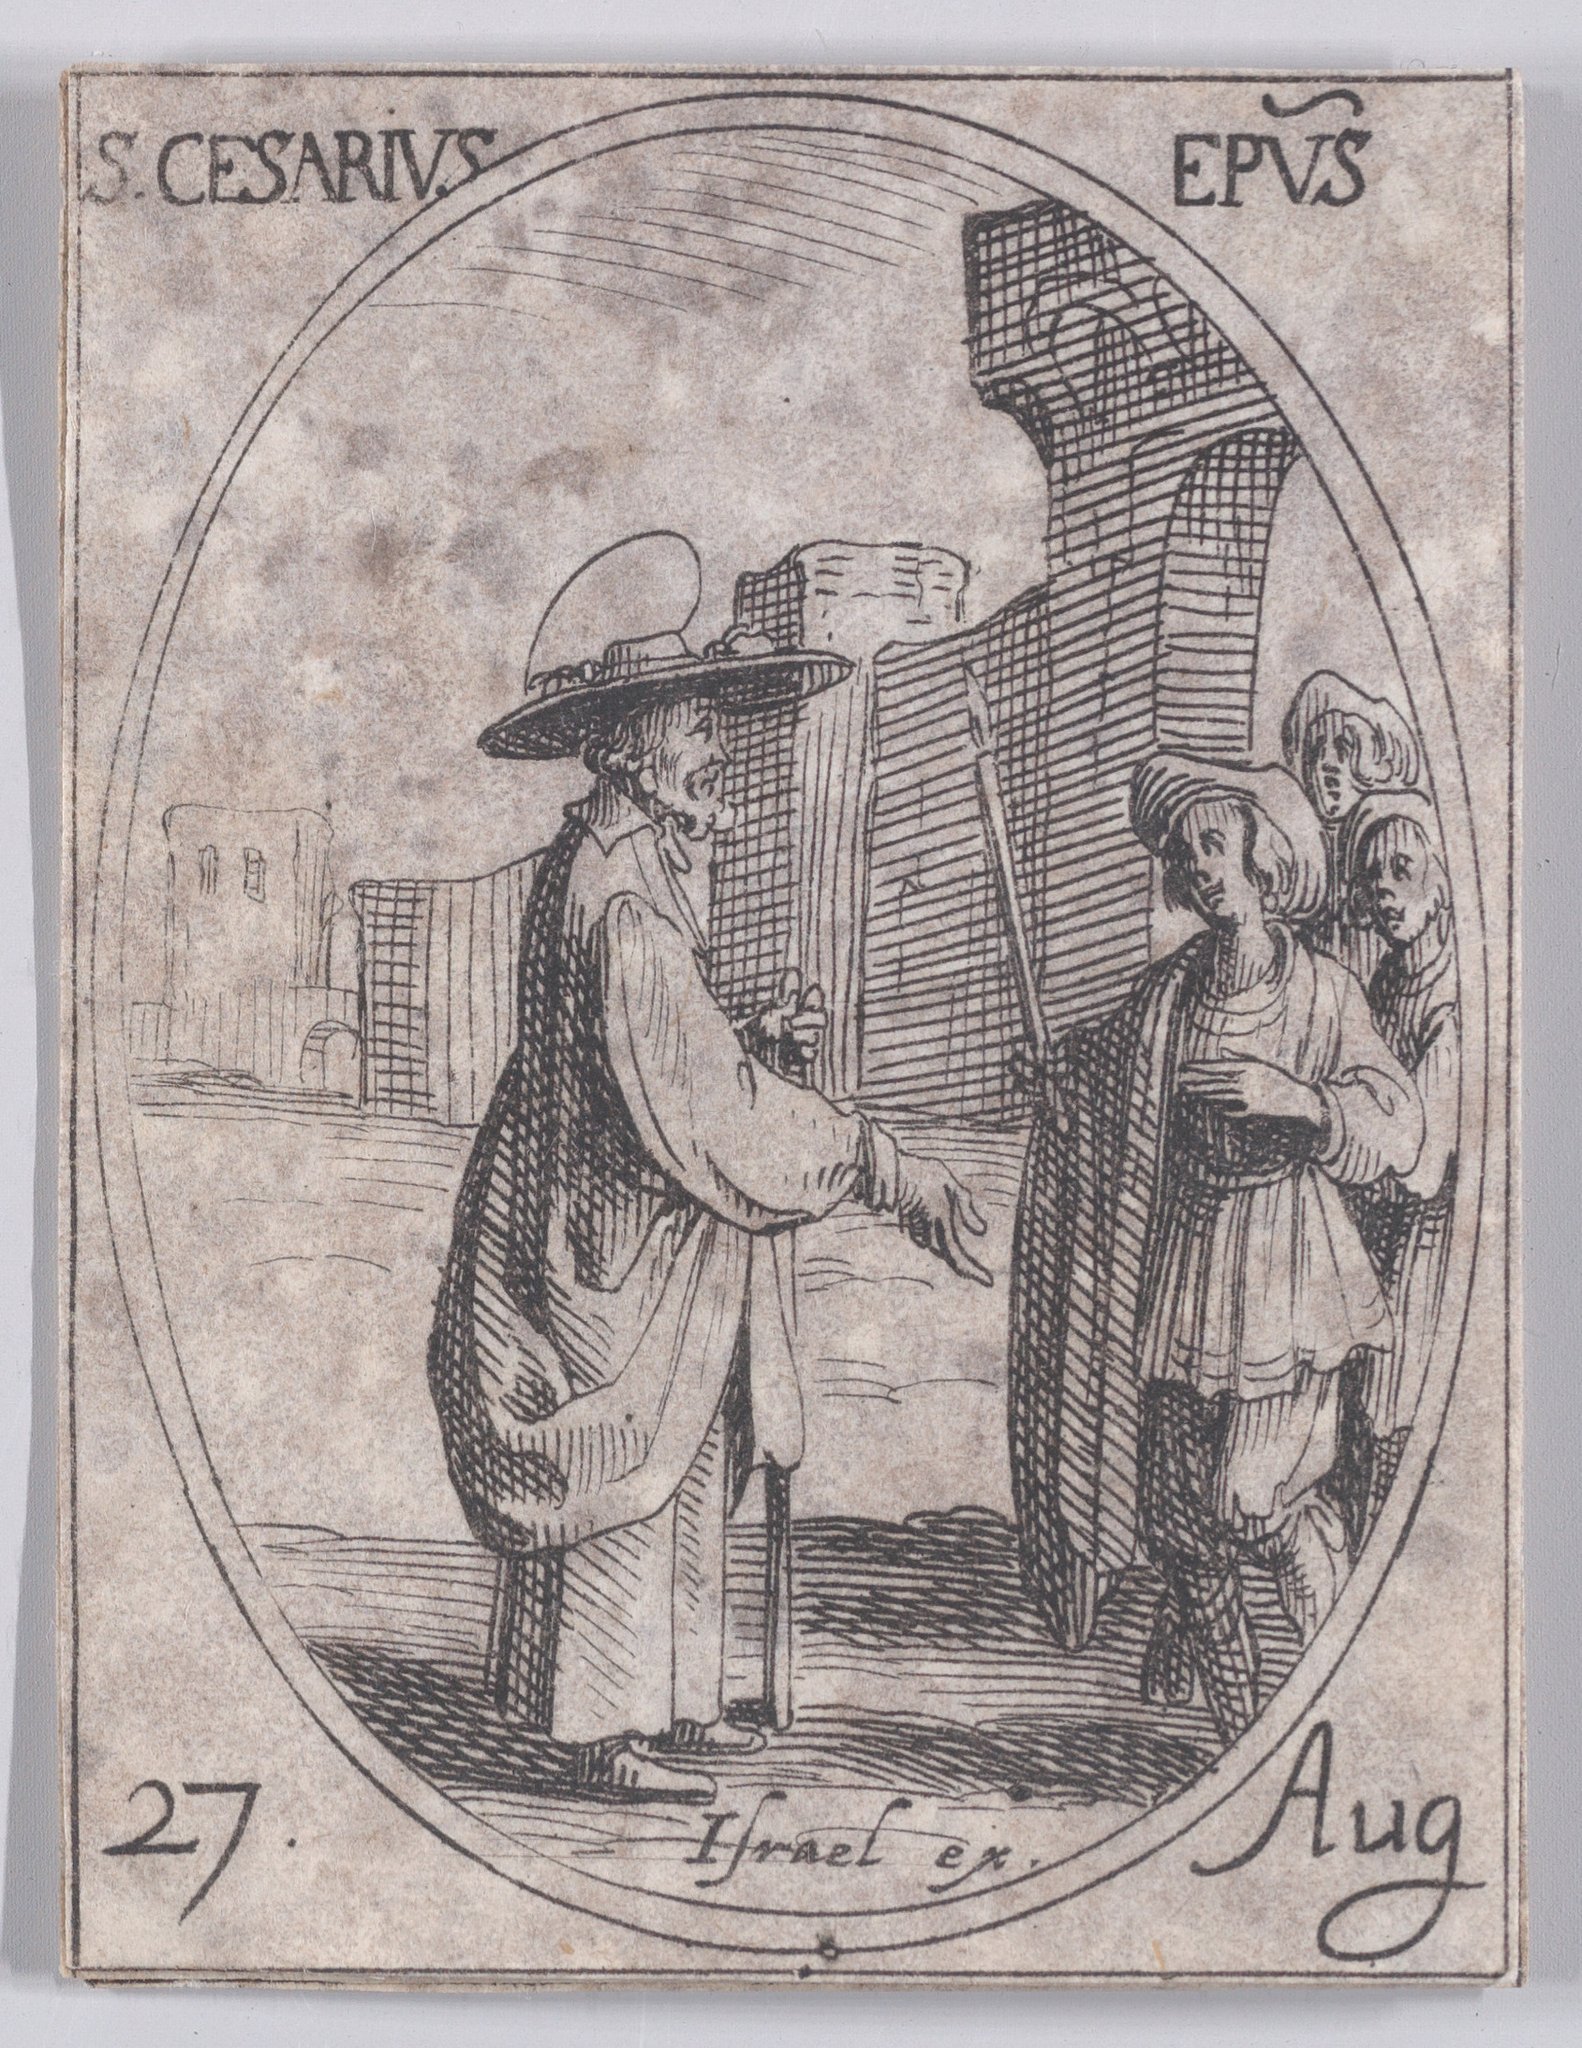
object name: print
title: S. Césaire, évêque (St. Caesarius, Bishop), August 27th, from "Les Images De Tous Les Saincts et Saintes de L'Année" (Images of All of the Saints and Religious Events of the Year)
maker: jacques callot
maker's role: artist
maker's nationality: french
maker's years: 1592-1635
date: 1636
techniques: etching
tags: men,saints